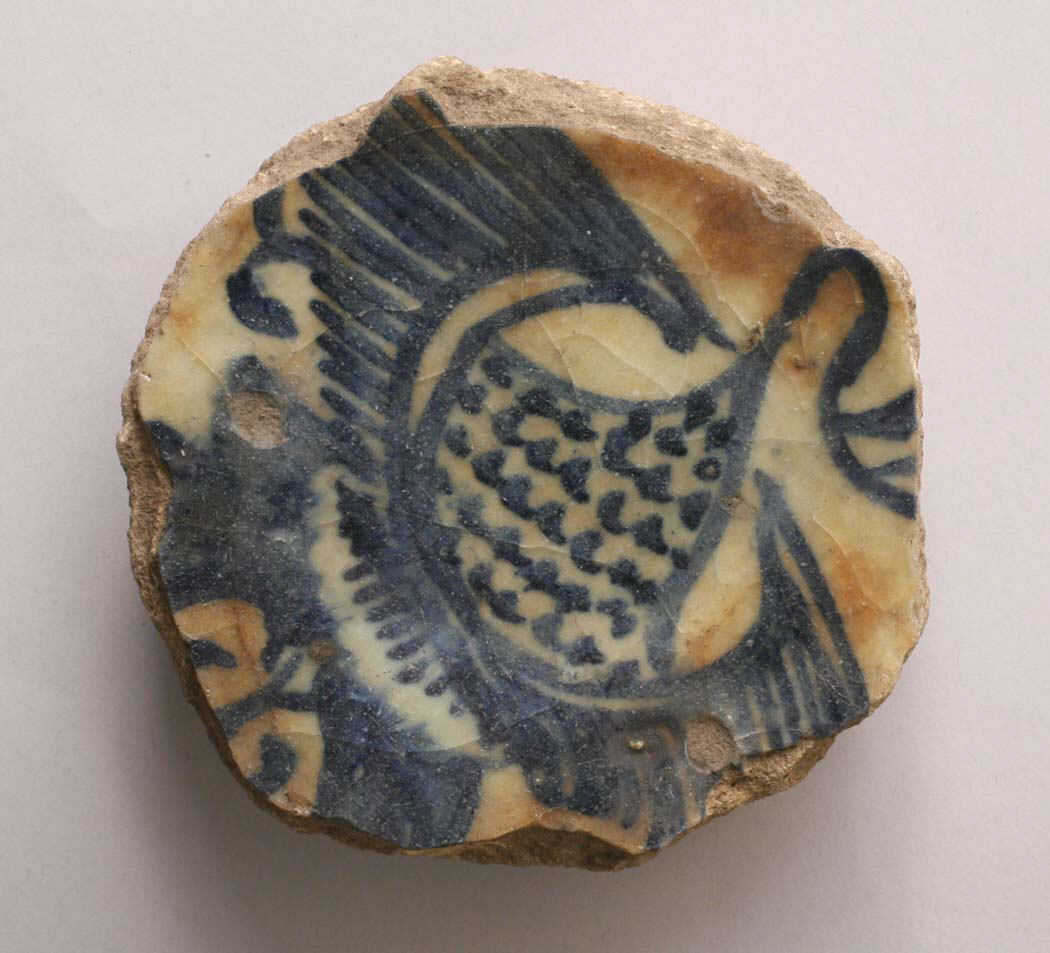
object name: fragment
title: Ceramic Fragment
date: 1301-1400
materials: glaze, stonepaste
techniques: painting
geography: egypt or syria